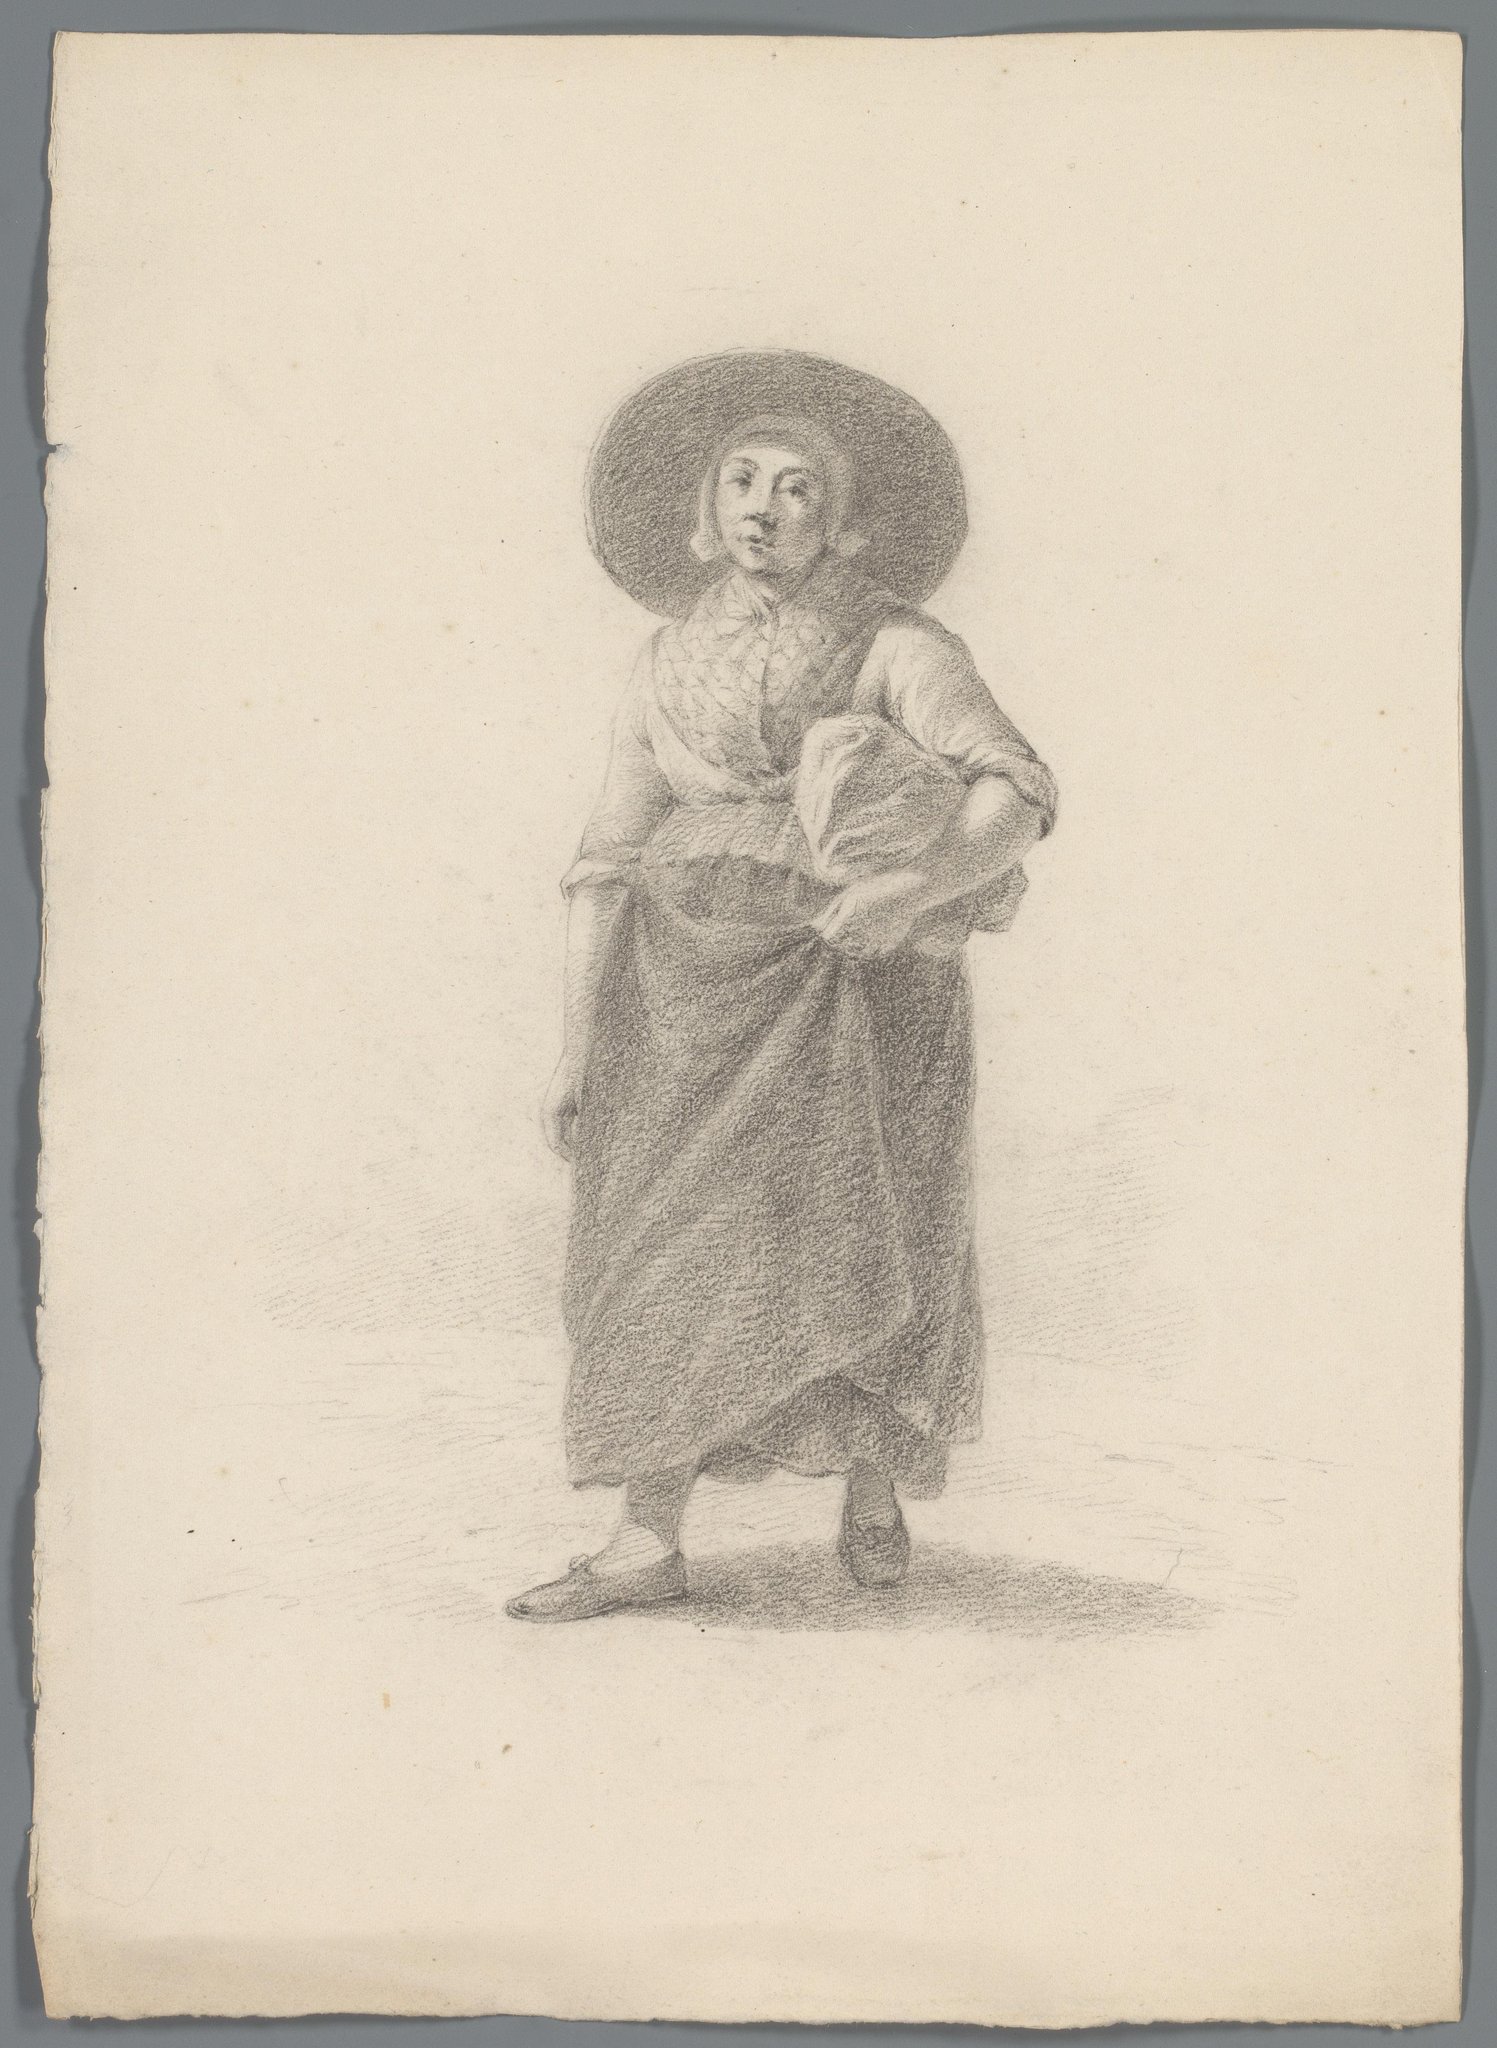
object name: drawing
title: Vrouw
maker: Anonymous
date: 1820-1830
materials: chalk, paper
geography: the hague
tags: adult woman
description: Tekeningen waarschijnlijk ontstaan bij het Haagse kunstgenootschap ‘Tot Nut der Tekenkunst’, waar twee keer per week tekenavonden werden georganiseerd met geklede modellen.